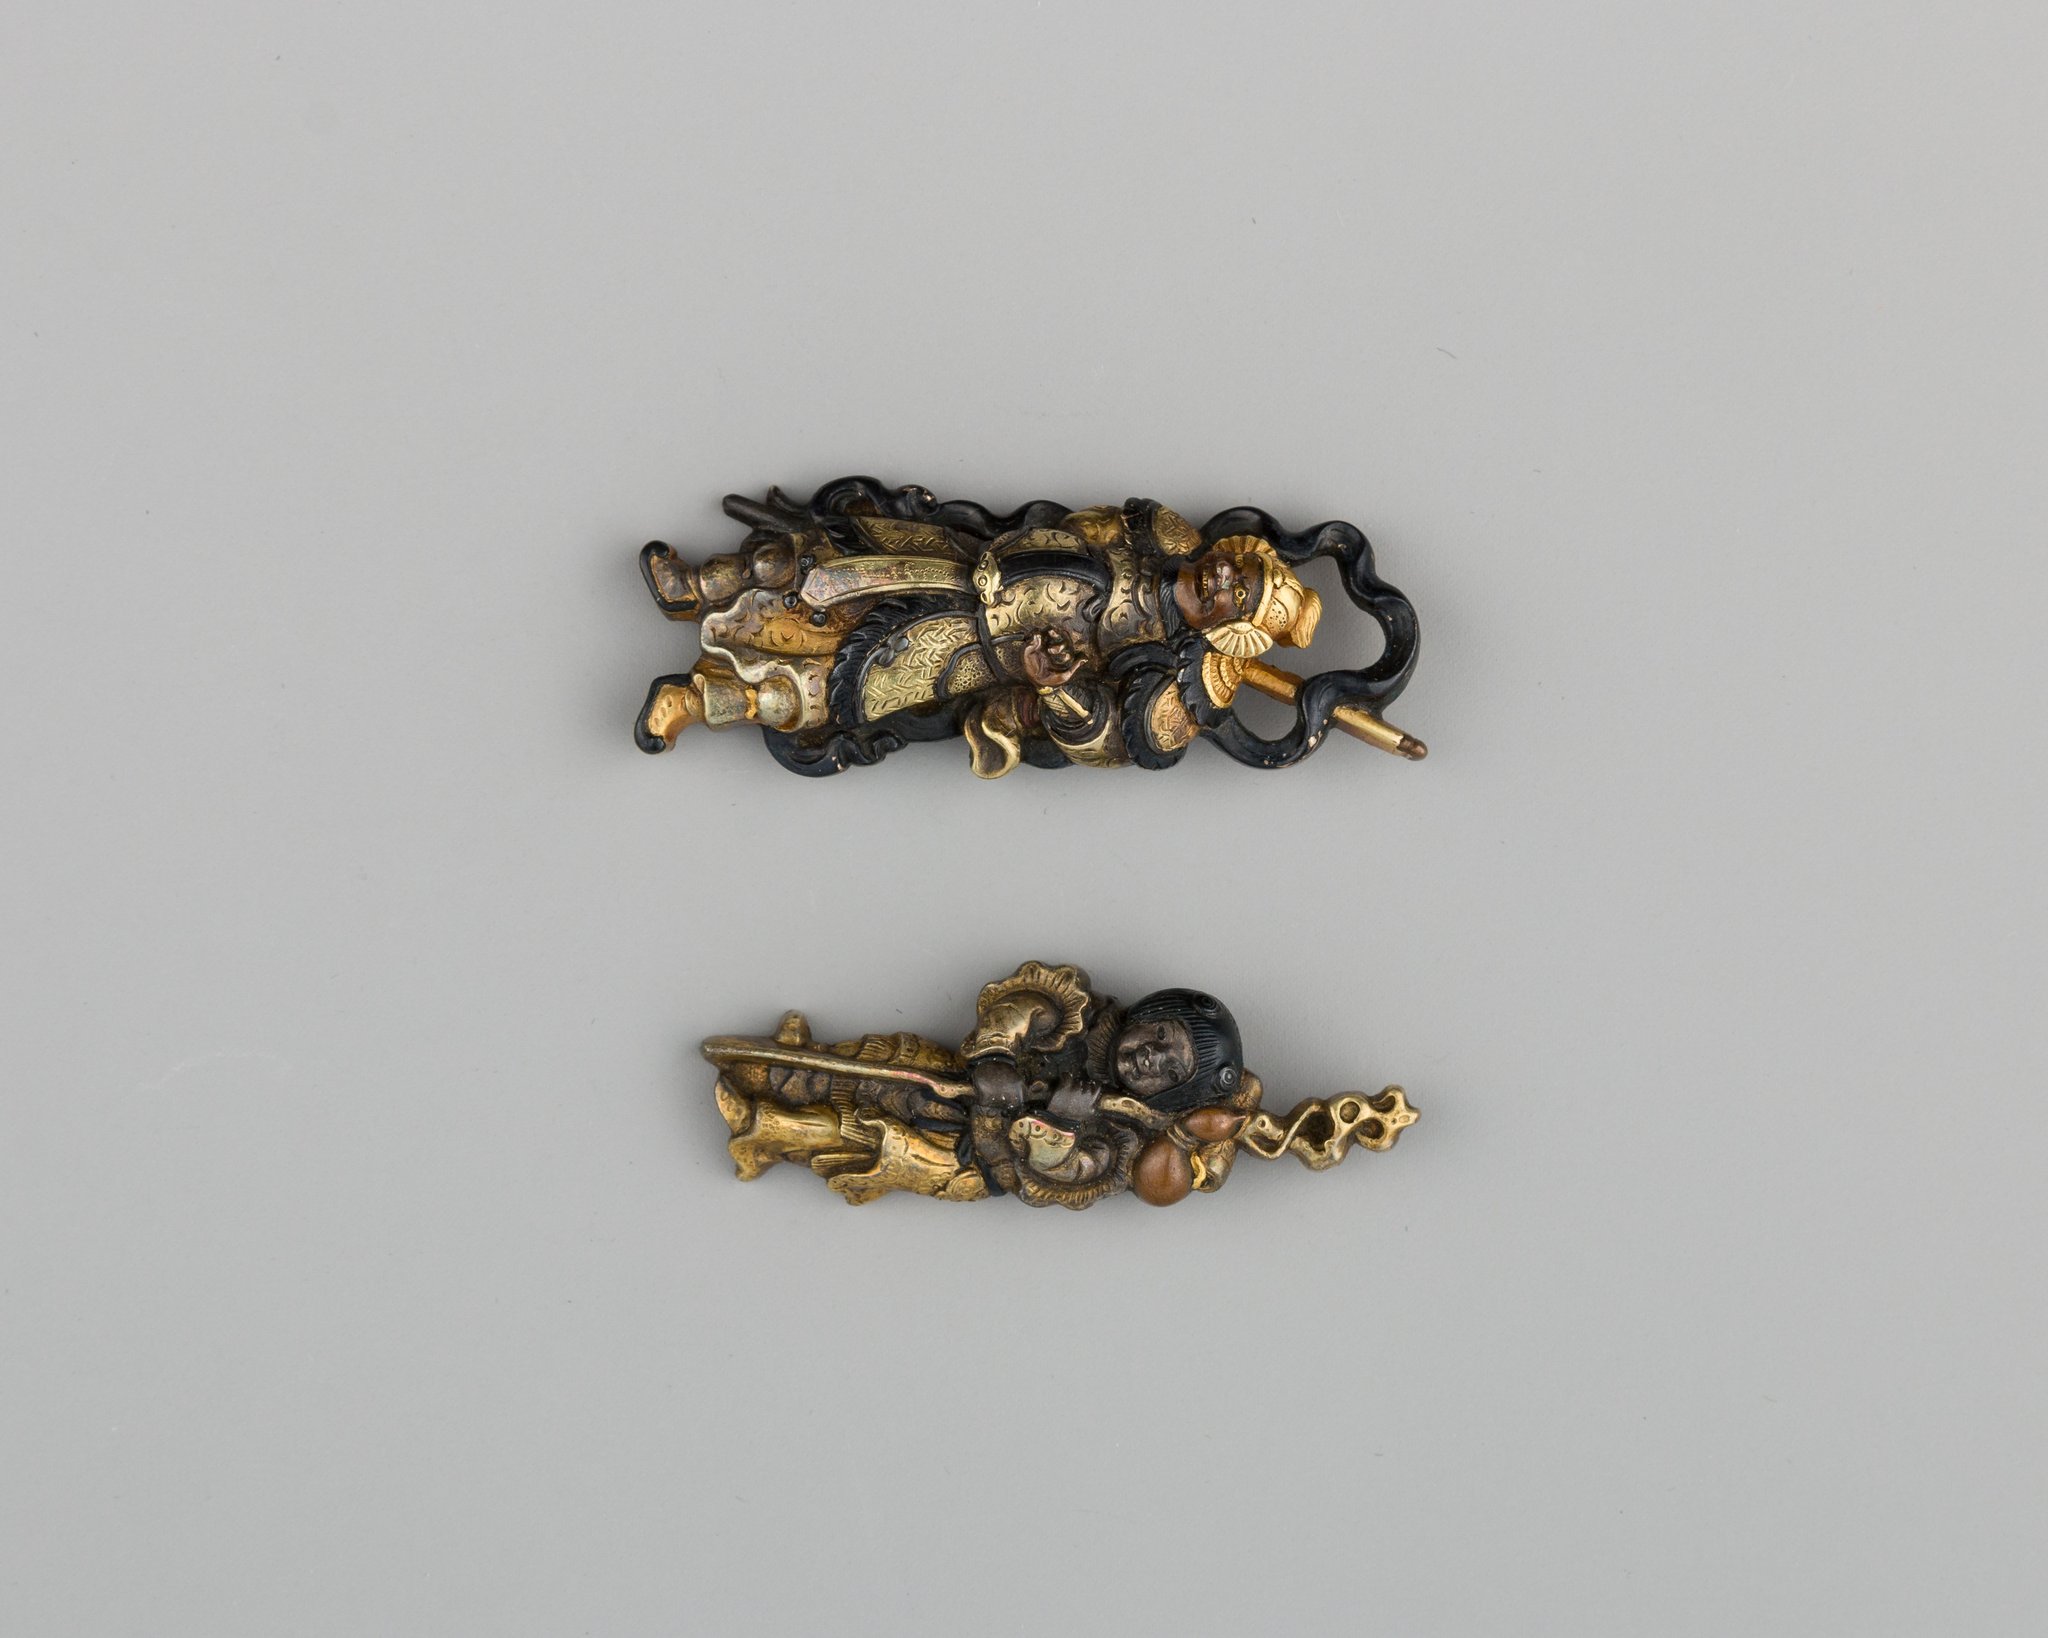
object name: pair of sword grip ornament menuki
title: Pair of sword-Grip Ornaments (Menuki)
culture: japanese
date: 1701-1800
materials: copper, gold alloy, gold, silver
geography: japan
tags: men